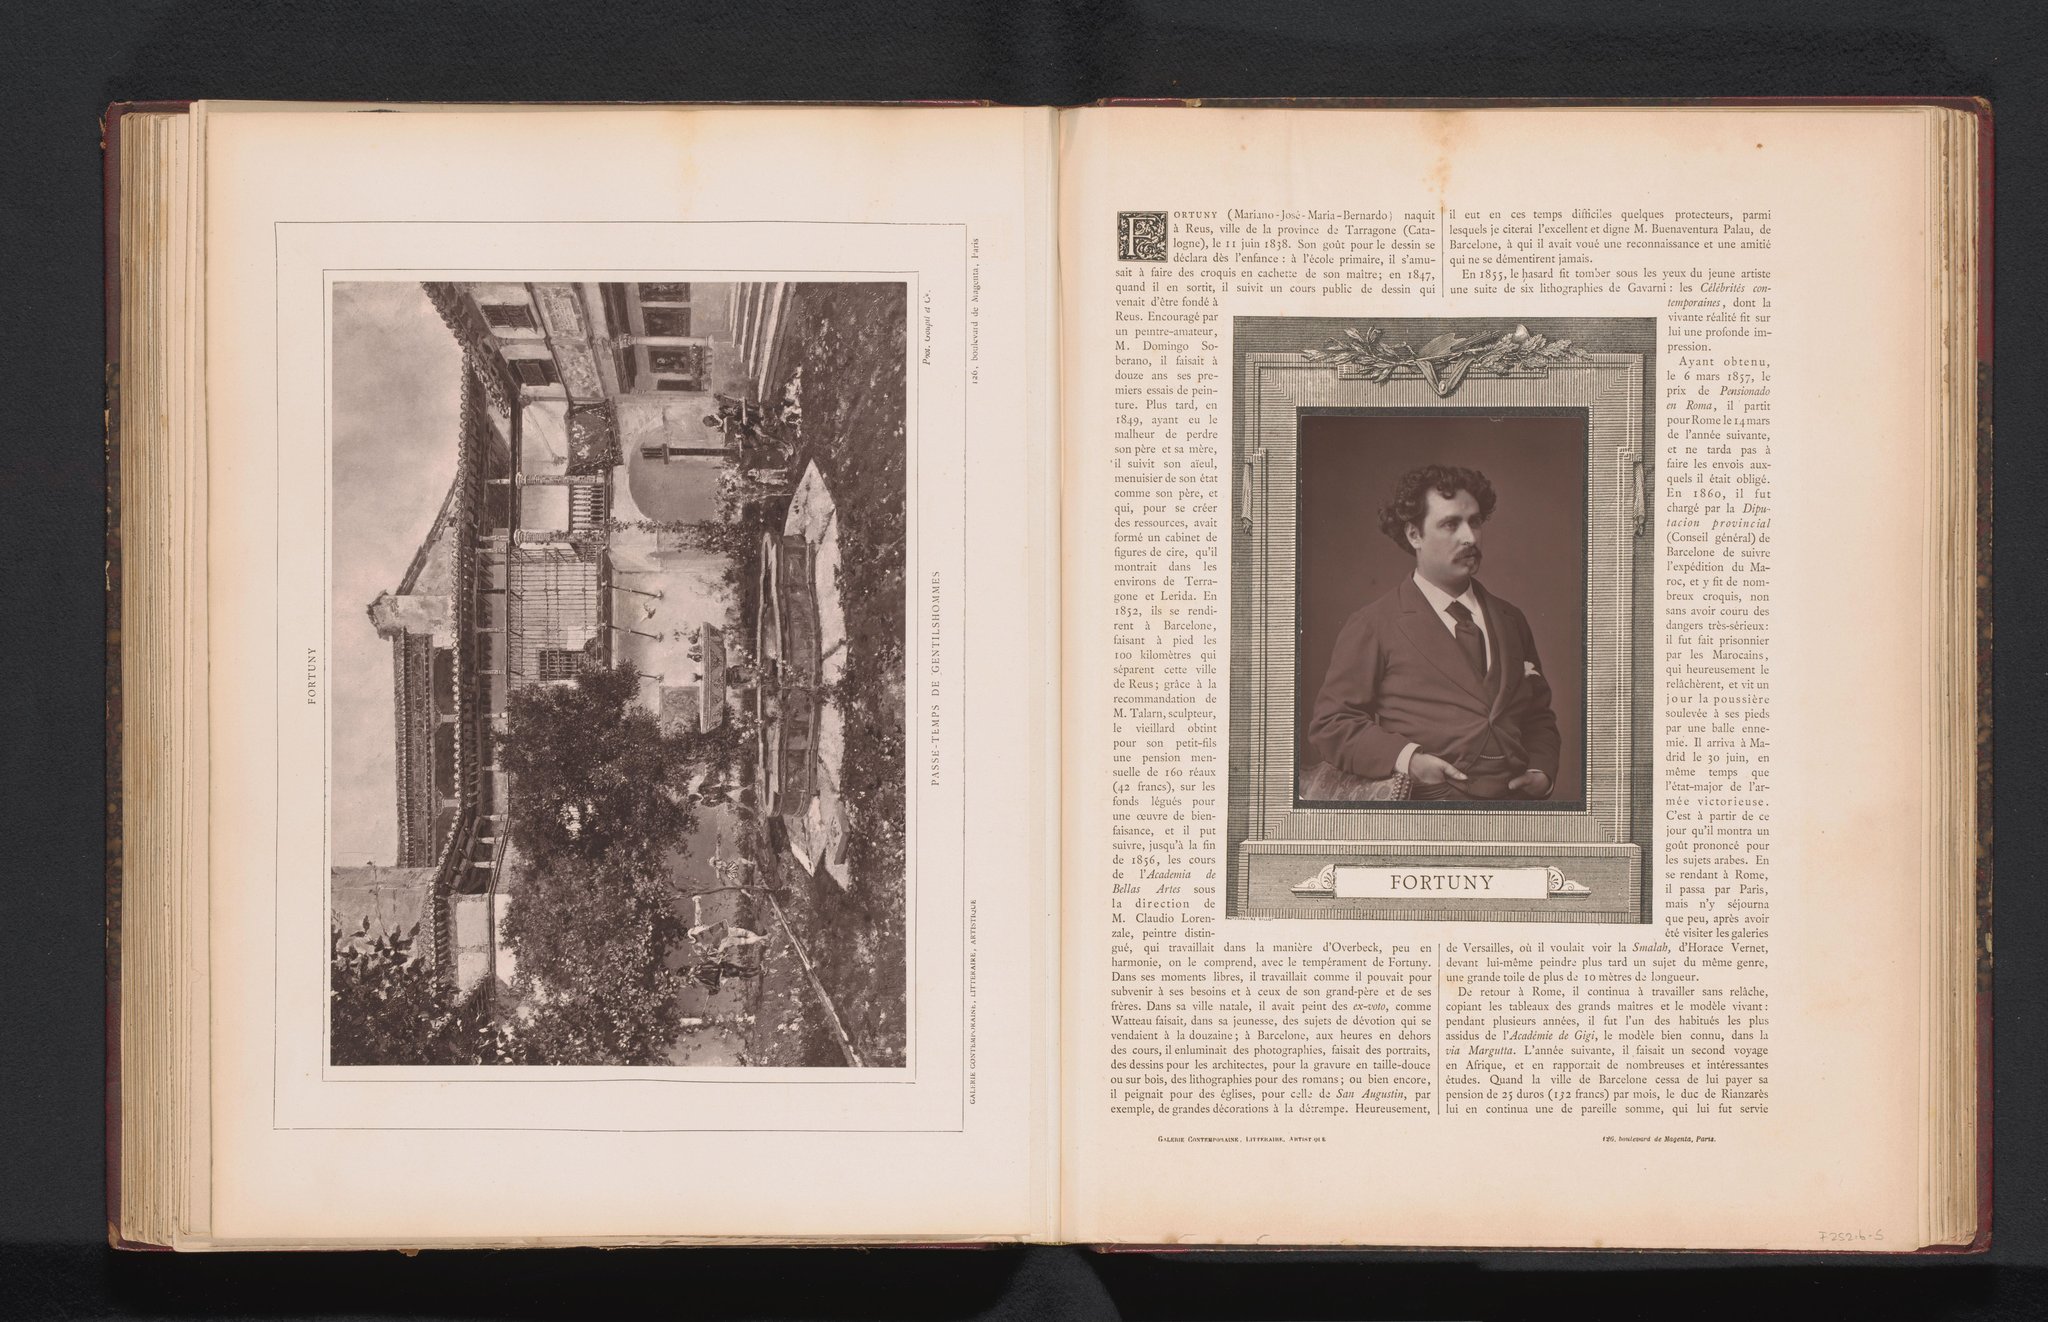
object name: reproduction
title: Reproductie van Passe-temps de gentilshommes door Marià Fortuny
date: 1871-1876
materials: paper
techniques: woodburytype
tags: adult man, courtyard, painting, drawing and the graphic arts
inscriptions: inscription: ‘Galerie Contemporaine, Littéraire, Artistique/ 126, boulevard de Magenta, Paris’